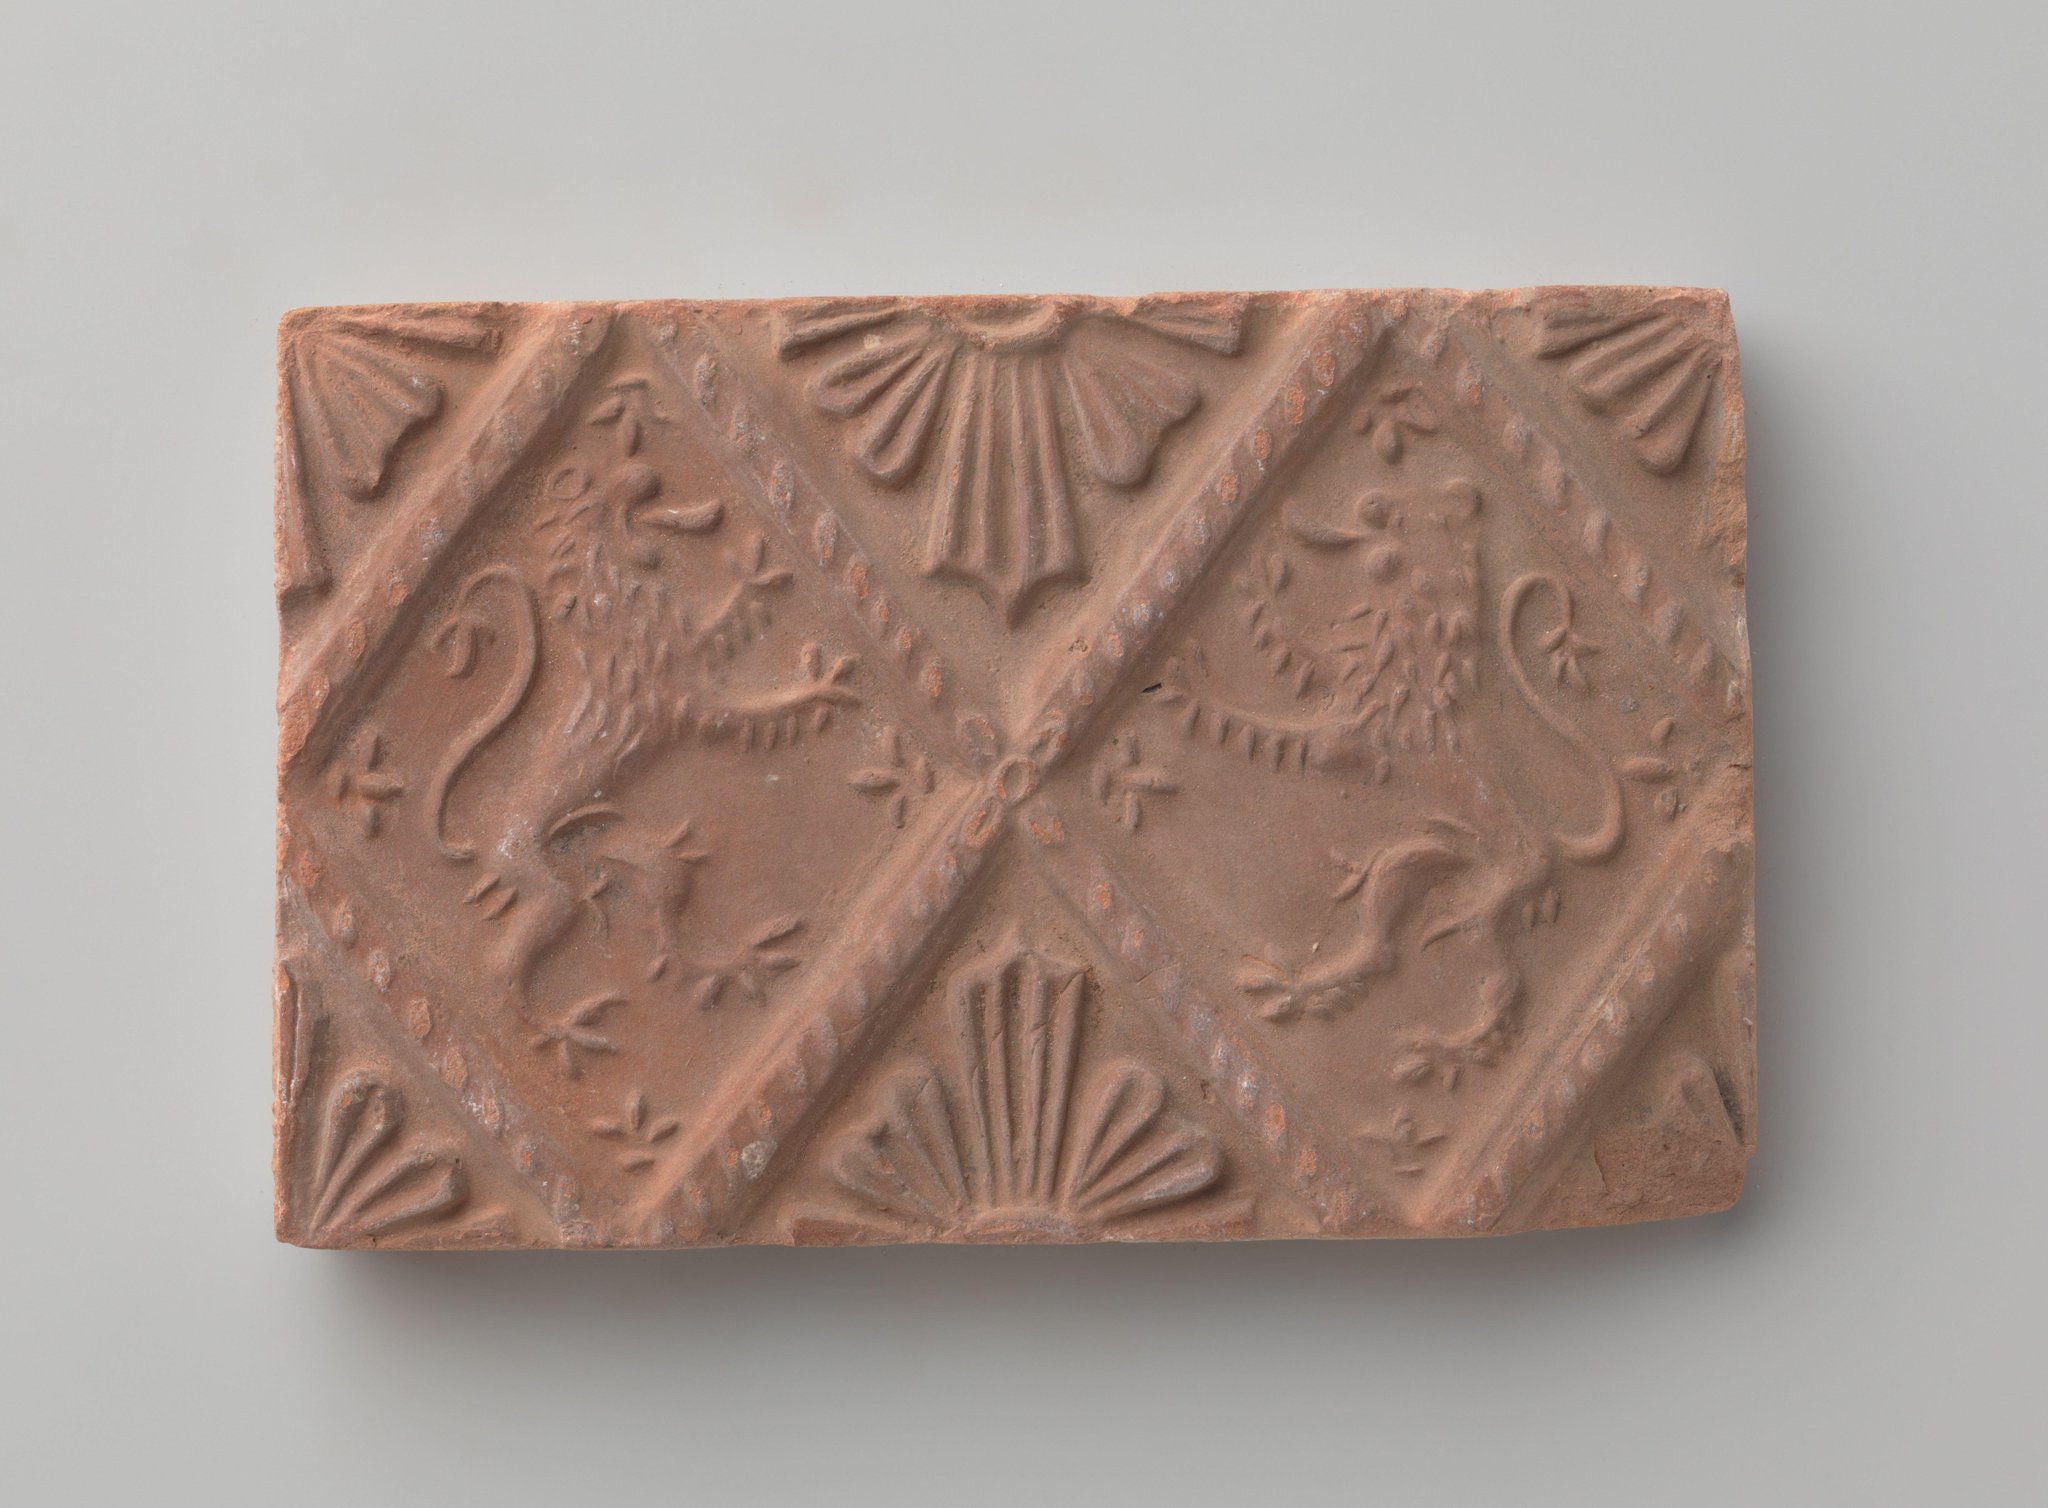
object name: hearthstone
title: Haardsteen met voorstelling van twee klimmende leeuwen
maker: Anonymous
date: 1875-1900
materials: earthenware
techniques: printing, firing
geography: netherlands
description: Haardsteen met voorstelling van twee klimmende leeuwen, geplaatst in geprofileerde ruit. De halve ruiten aan de boven- en onderkant zijn opgevuld met stermotief.